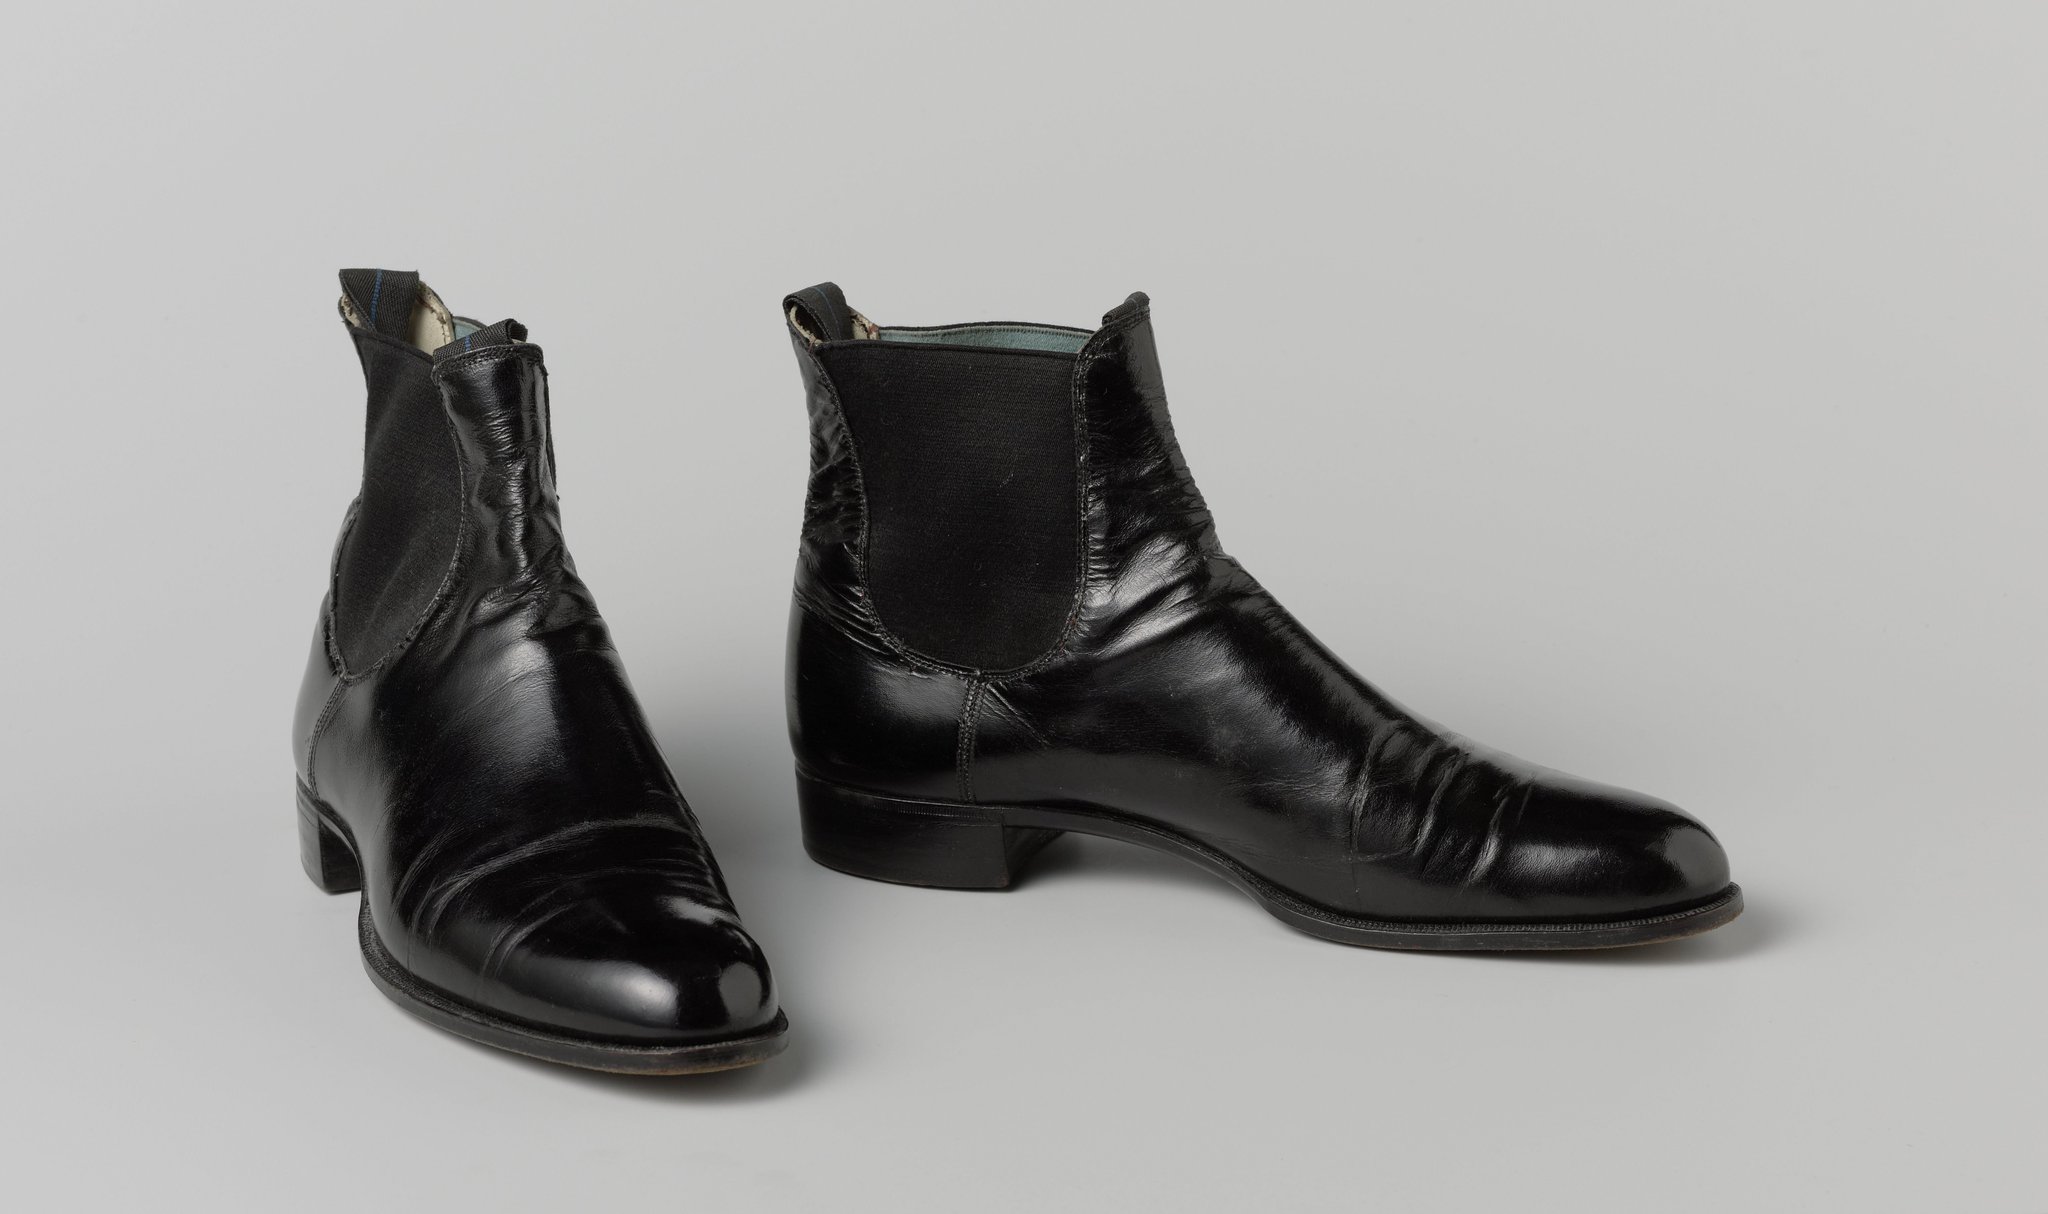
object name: shoe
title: Bottine van ambassadeur Allard Merens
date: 1940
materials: iron, leather, rubber, textile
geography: china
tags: the hague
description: Laklederen bottine. Behorend bij de diplomatieke ambtskleding van ambassadeur Allard Merens.